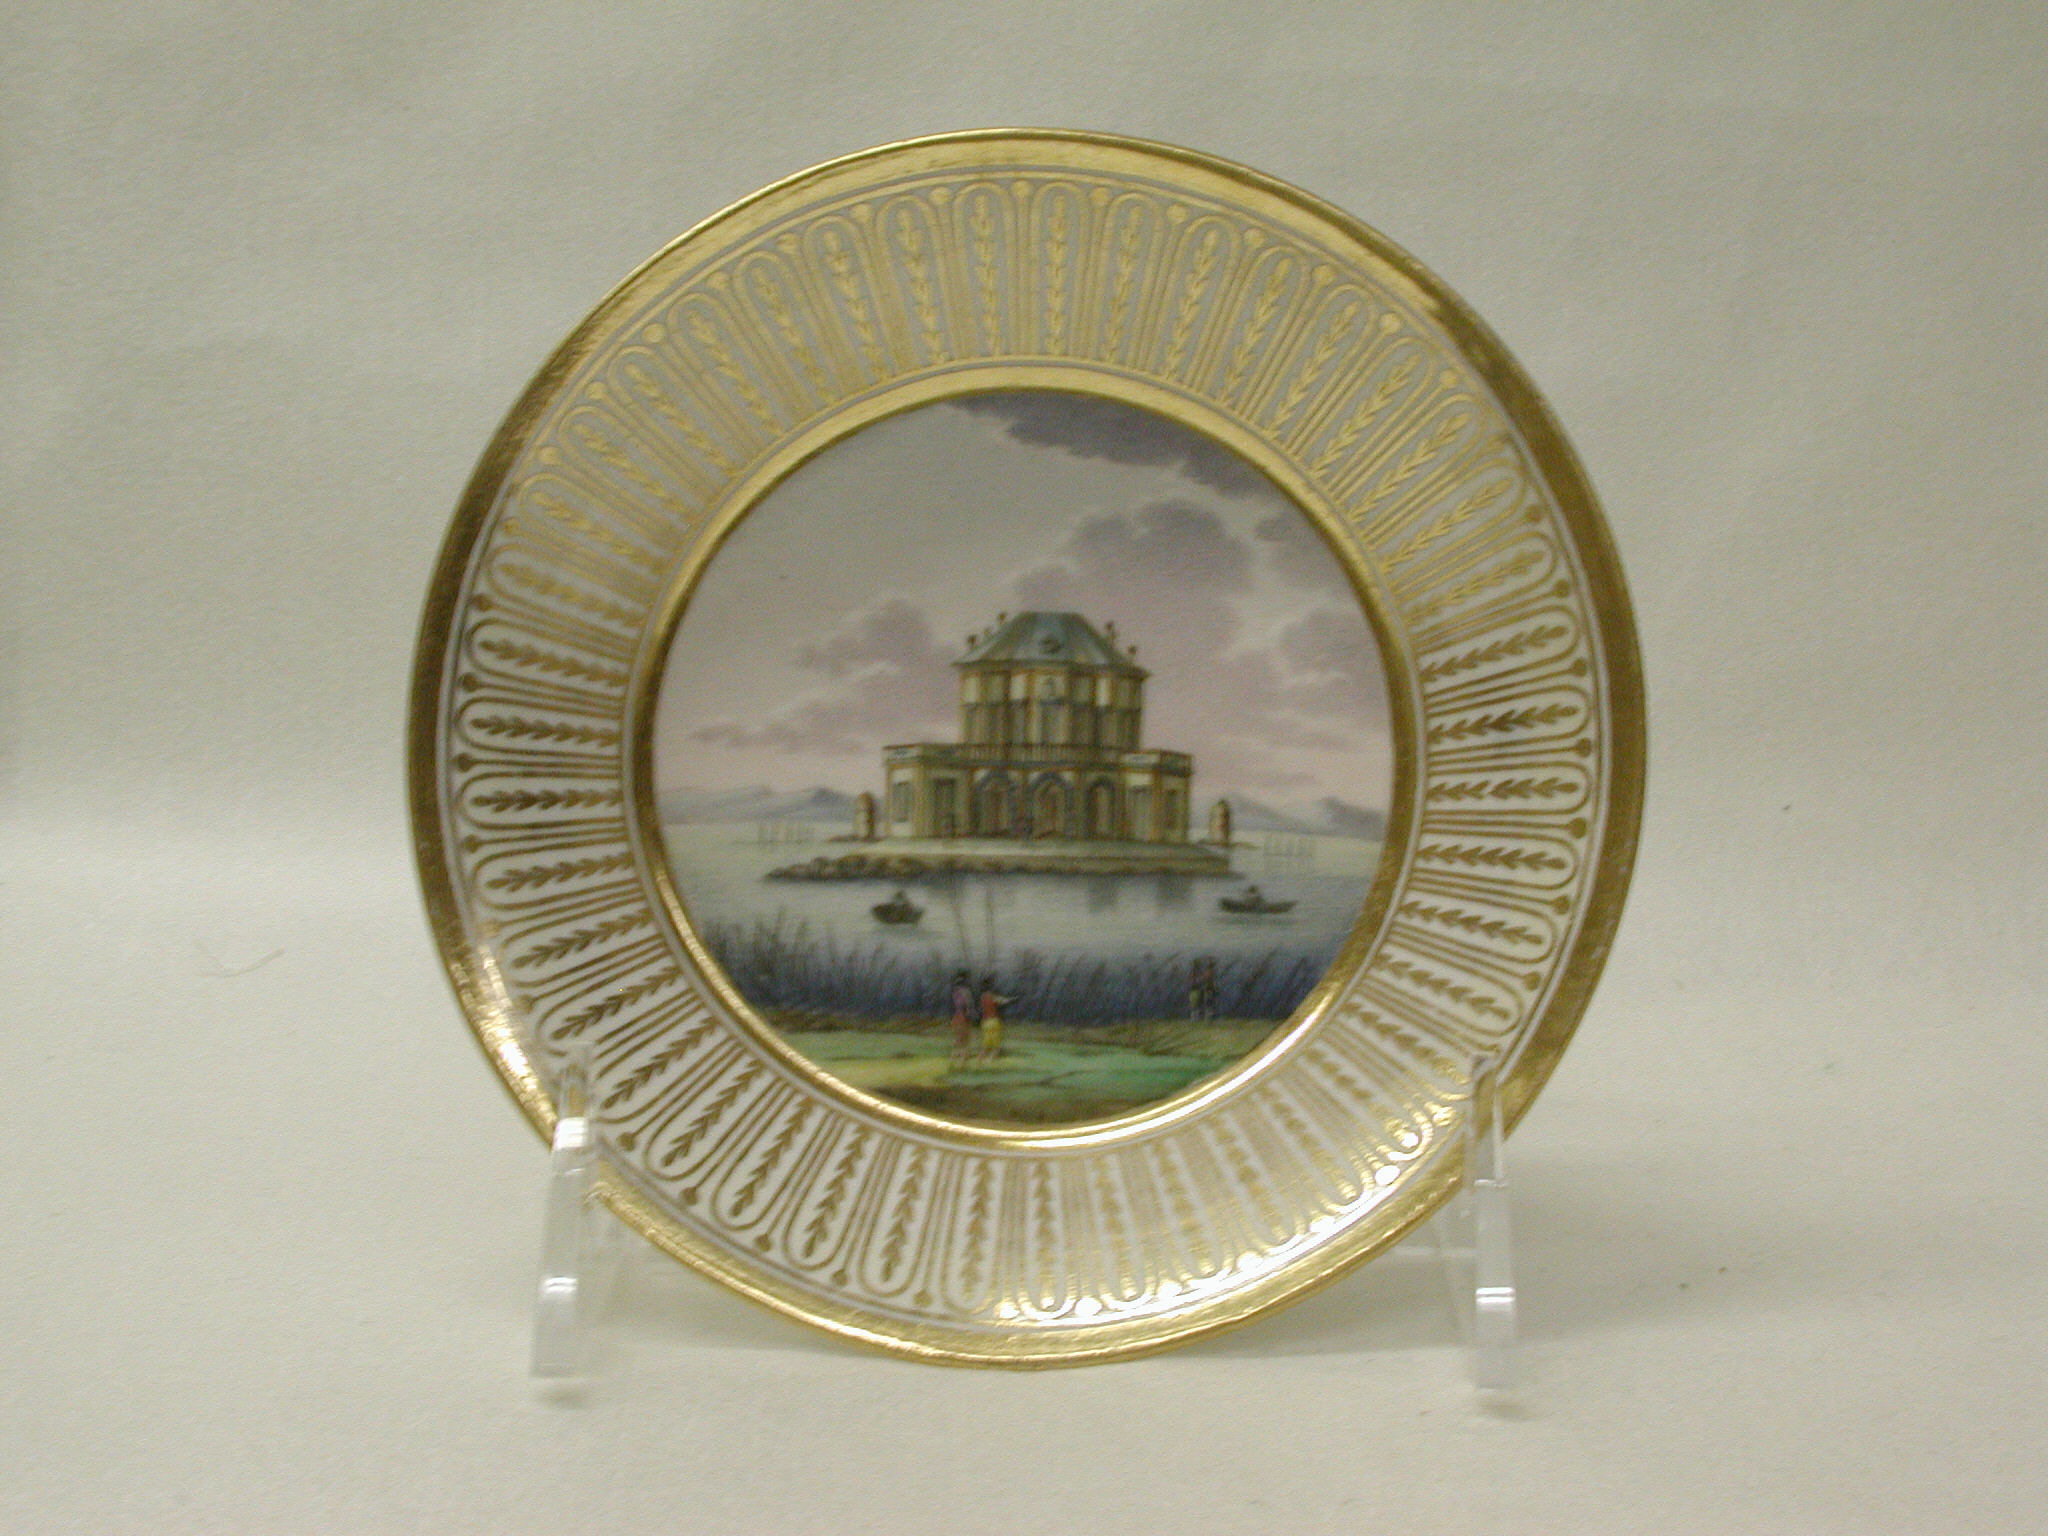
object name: saucer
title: Saucer (part of a service)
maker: royal porcelain manufactory, naples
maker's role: manufactory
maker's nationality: italian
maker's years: 1759-1819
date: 1790-1800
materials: soft paste porcelain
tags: buildings